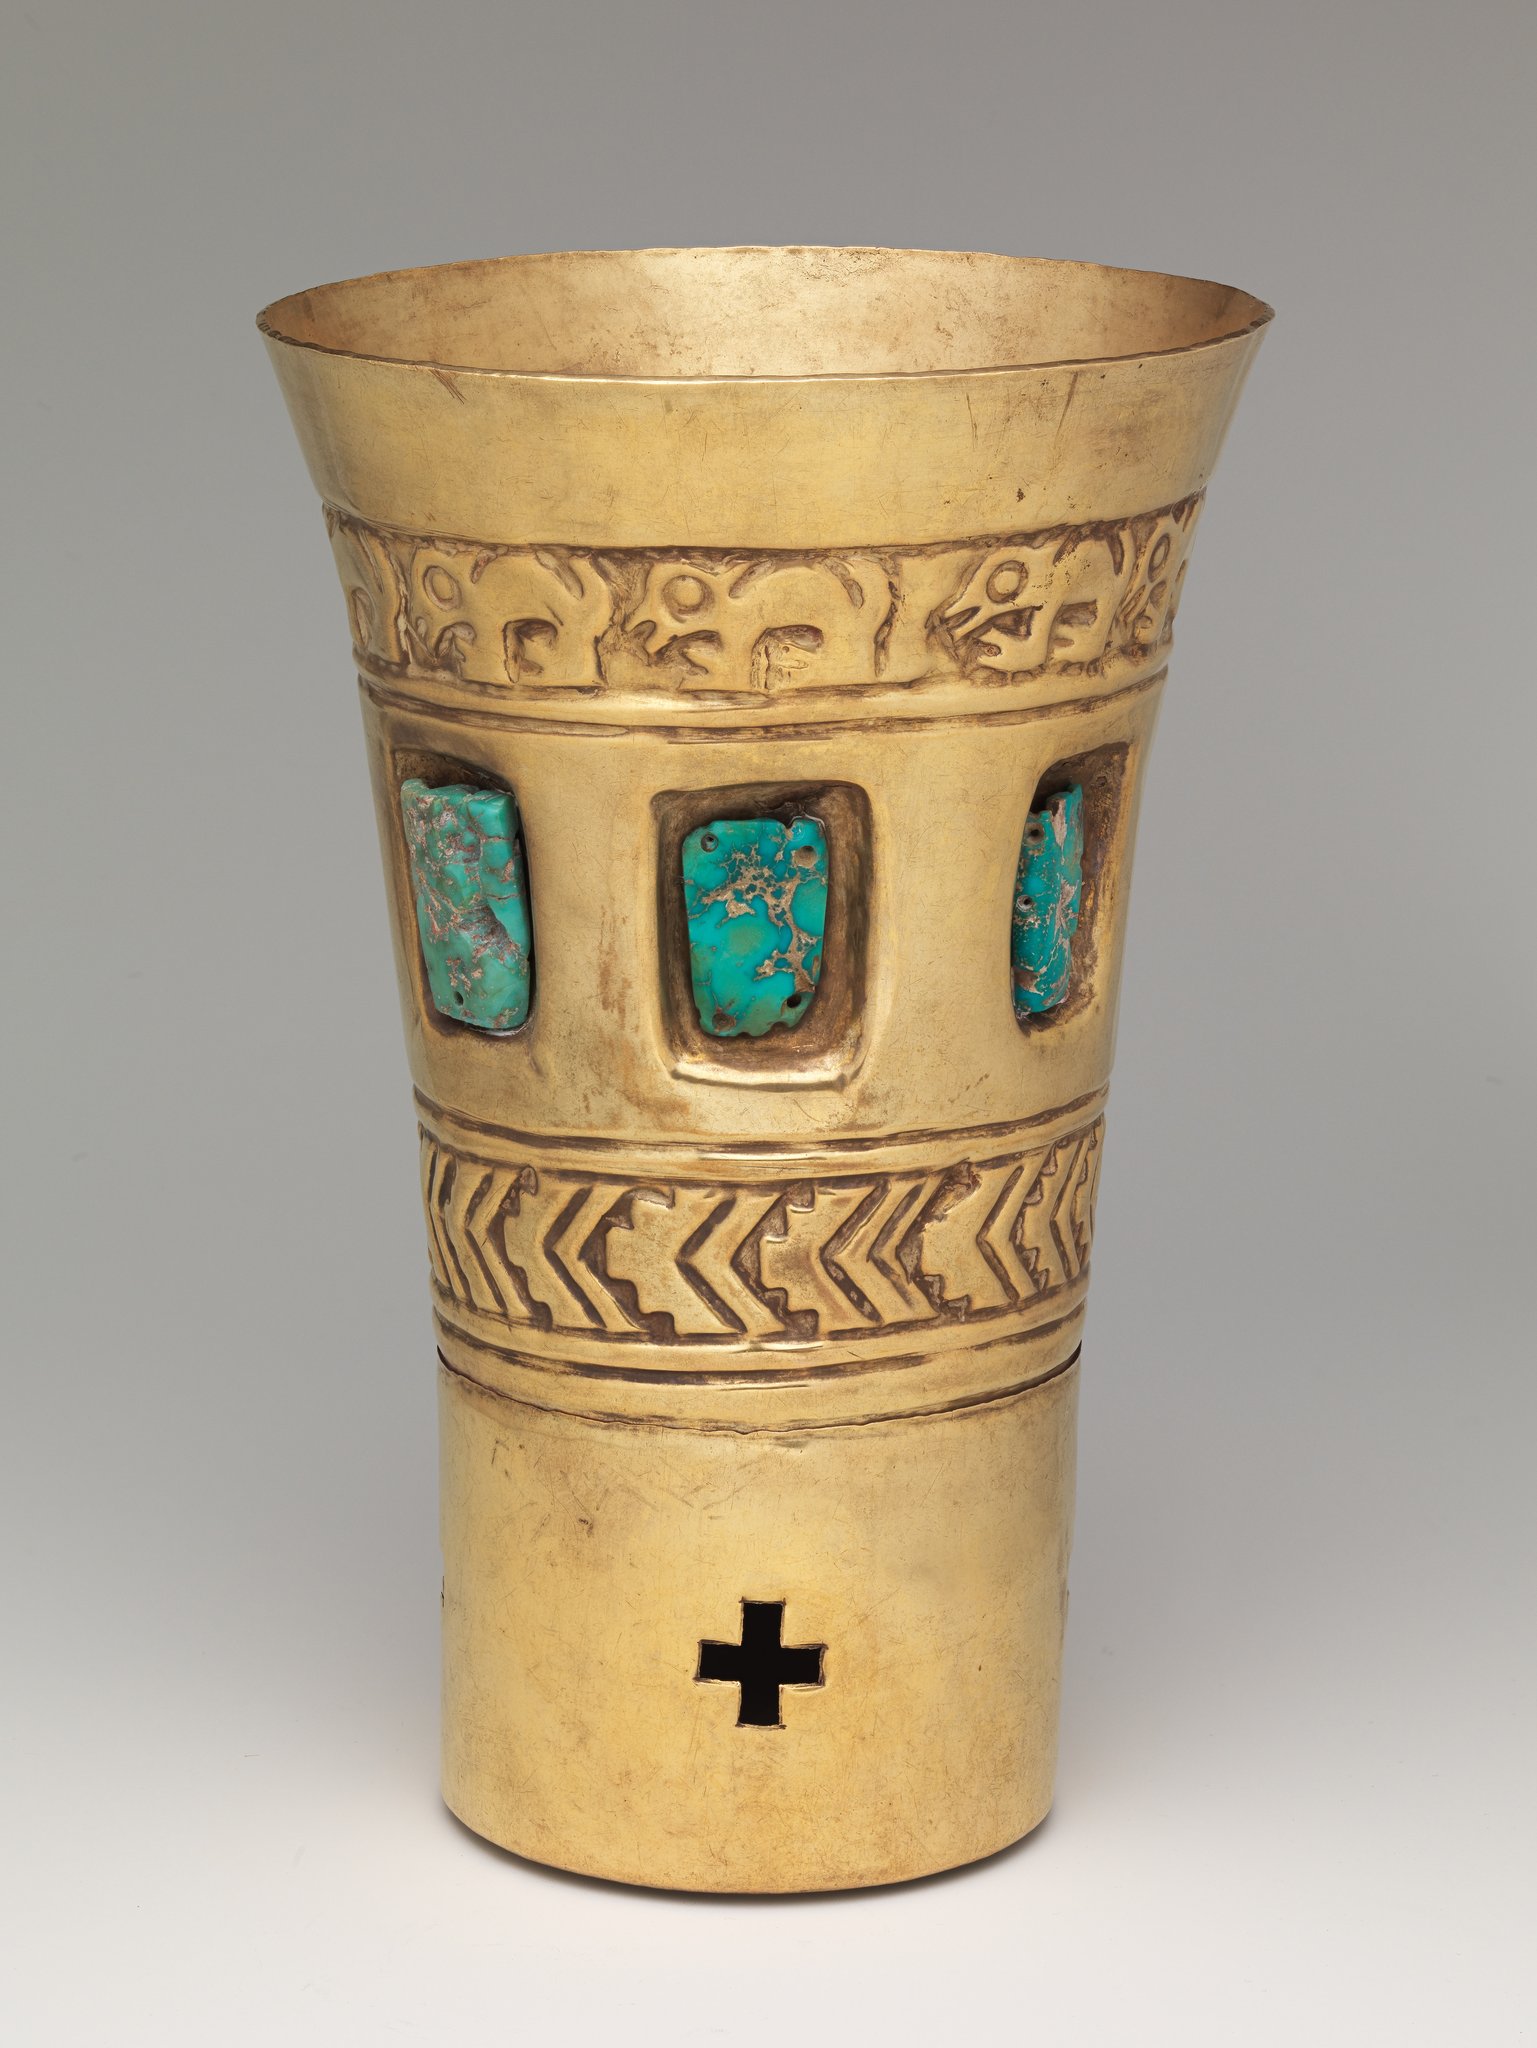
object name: beaker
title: Beaker with rattle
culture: lambayeque, sicán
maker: lambayeque (sicán) artist(s)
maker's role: artist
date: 900-1100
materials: gold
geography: peru